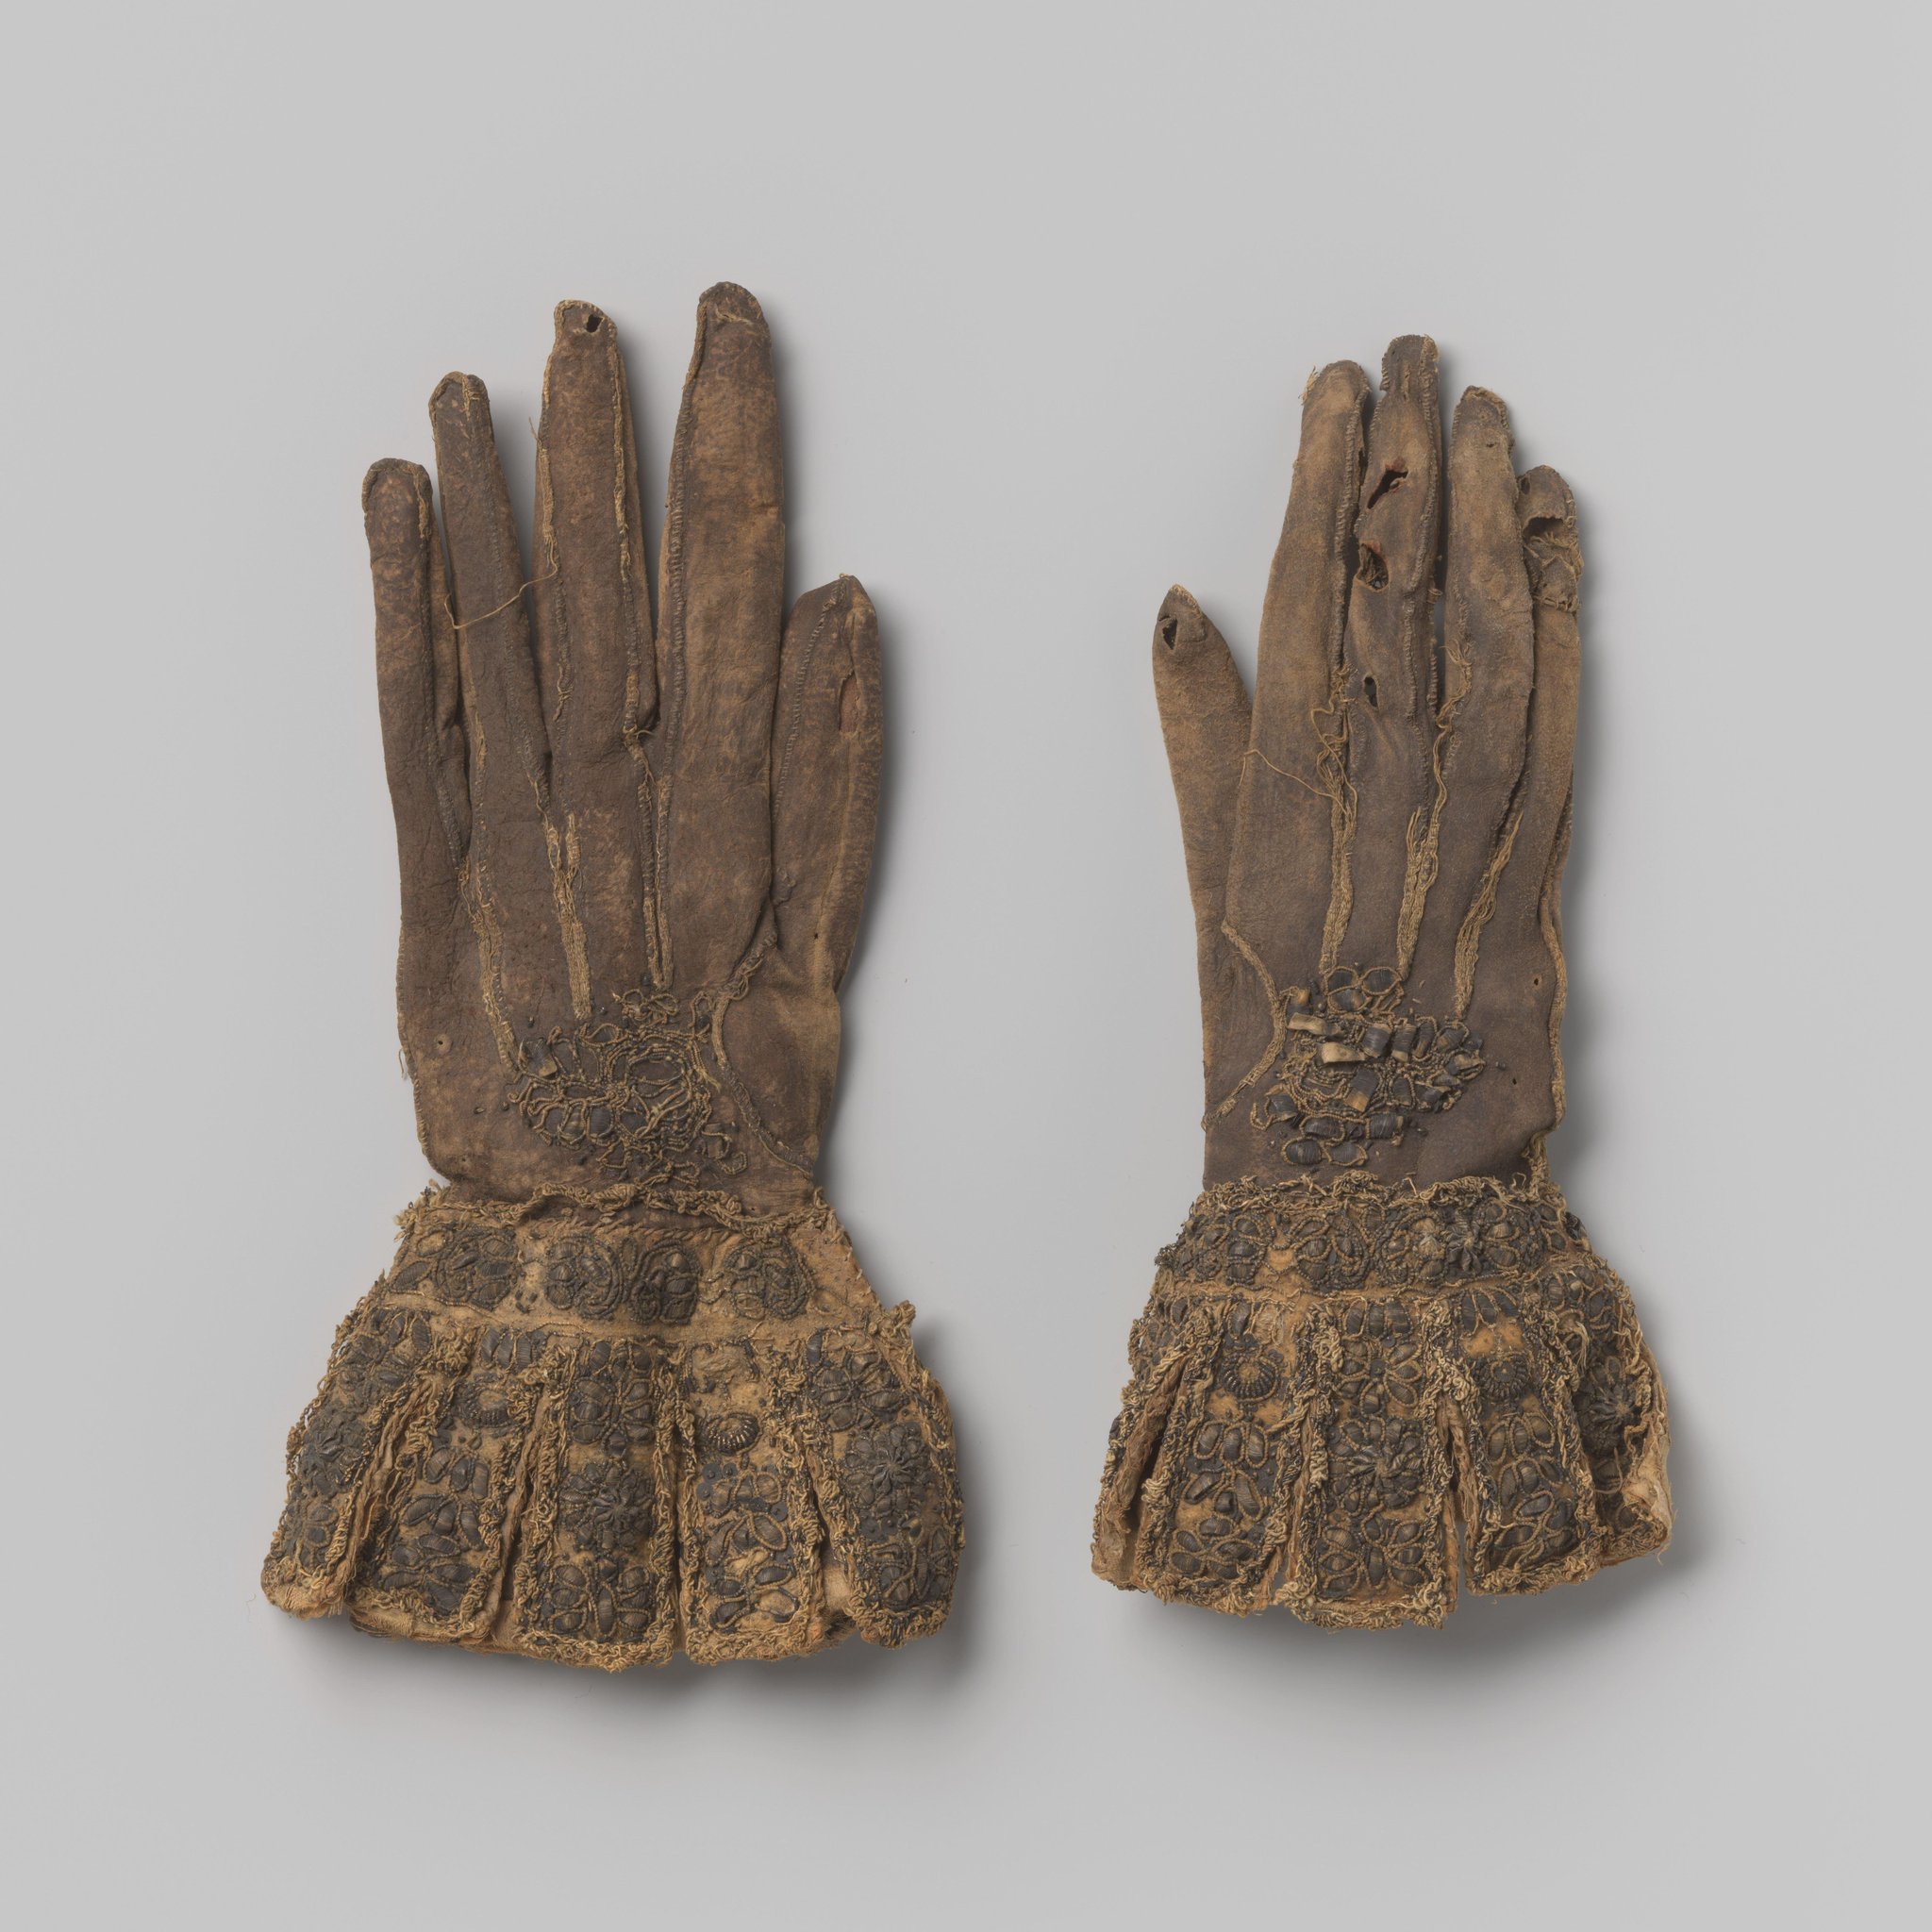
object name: clothing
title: Handschoen van bruin leer met een borduursel van zijde en zilverdraad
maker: Anonymous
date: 1600-1699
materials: leather, silk, thread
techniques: embroidered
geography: western europe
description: Rechterhandschoen van bruin wasleer, met geschulpte zijden kap. Op de kap en rug geborduurd met bloemen in metaaldraad, en lovers. Zeer vergaan.